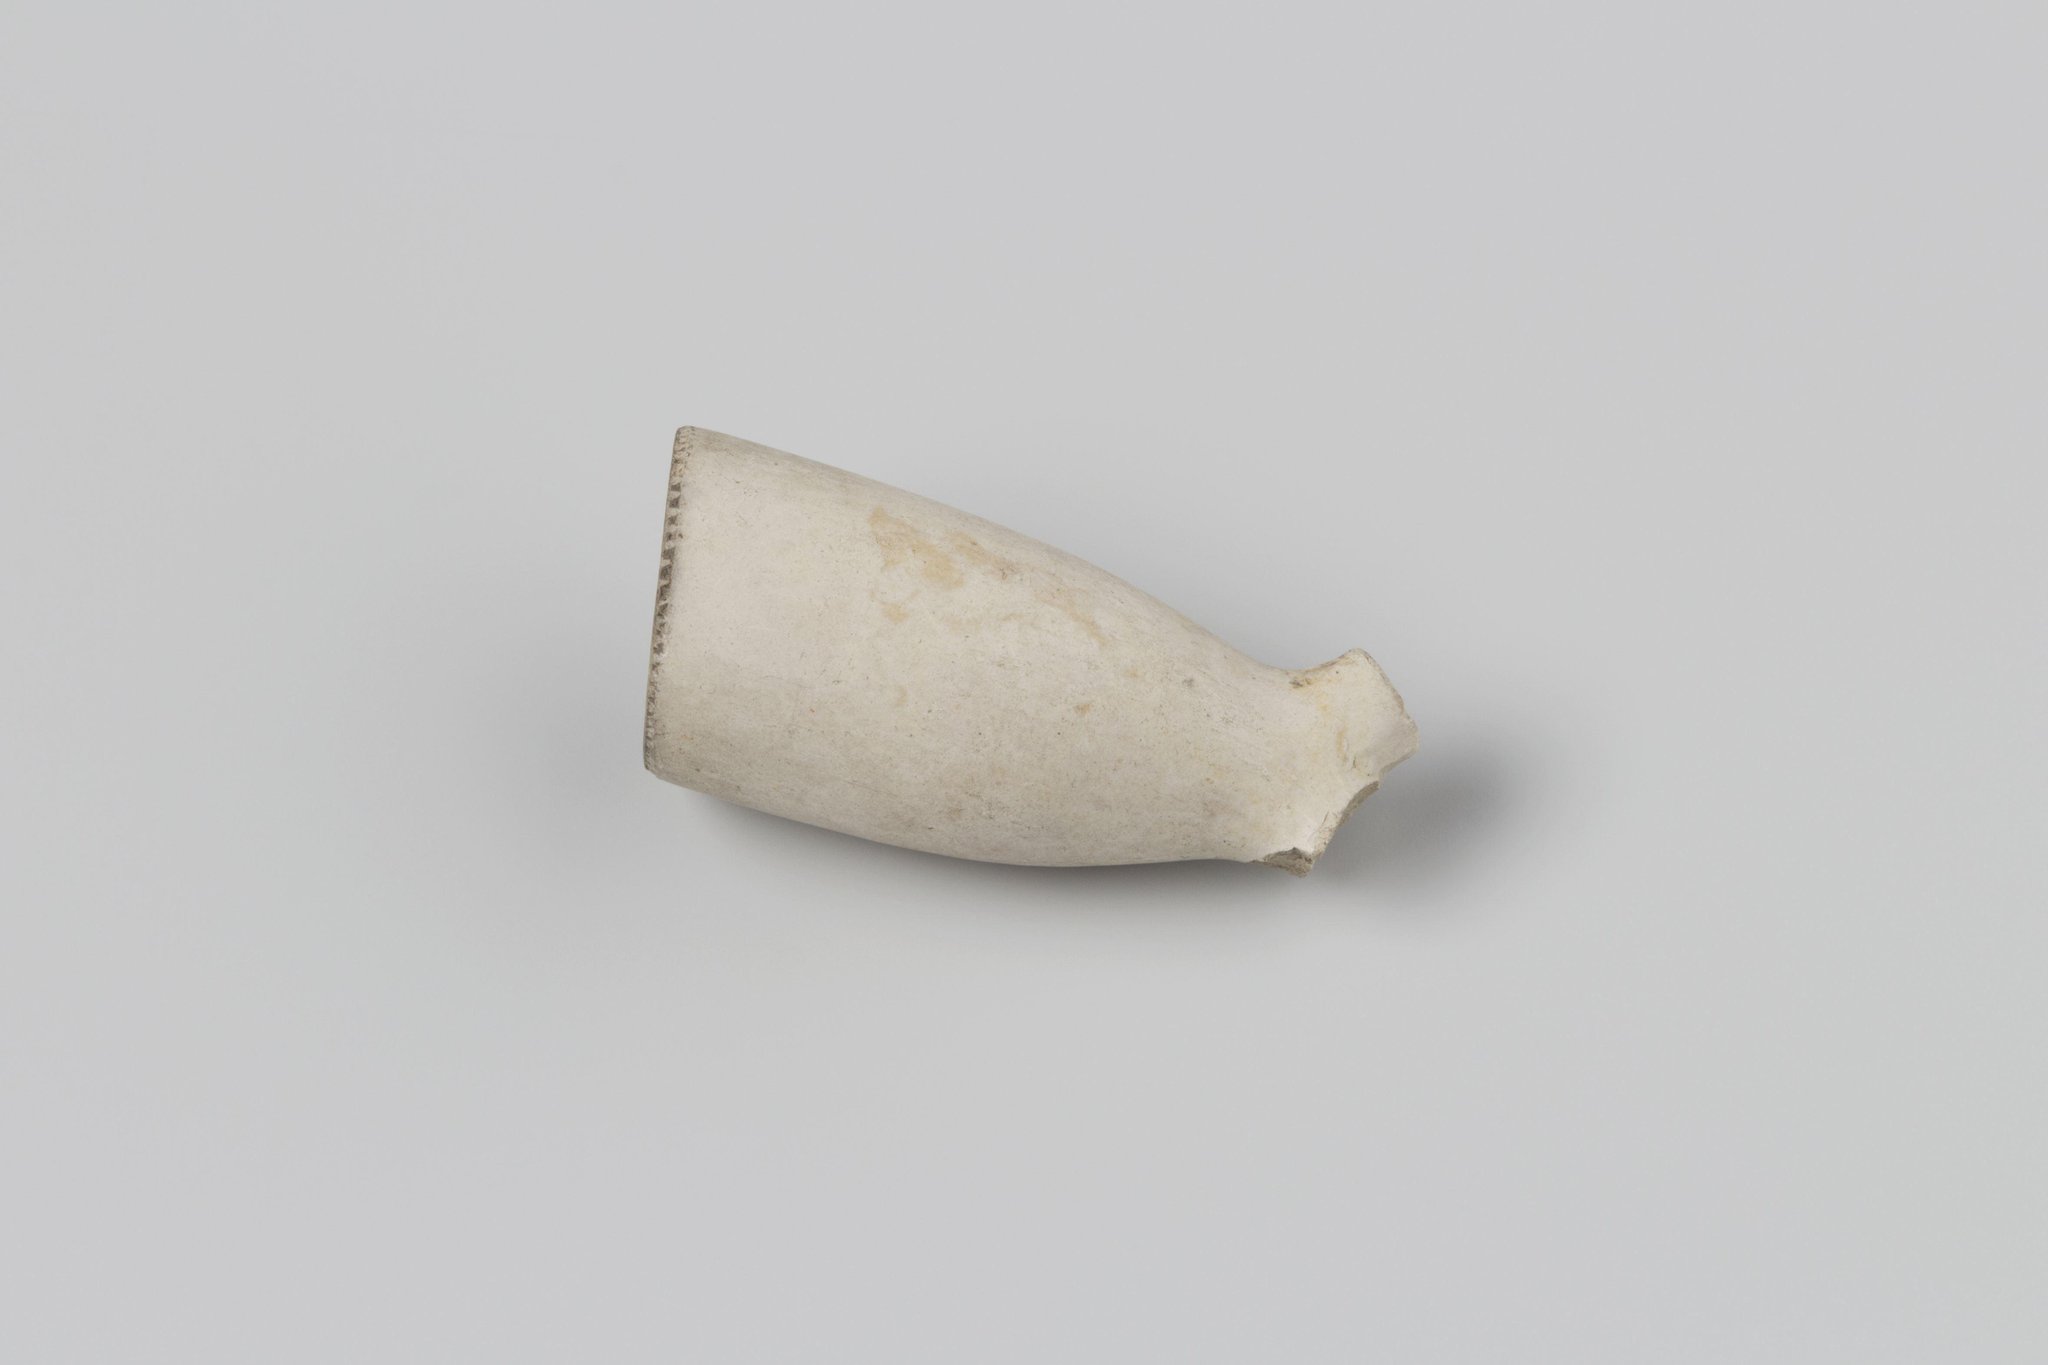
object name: pipe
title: Fragment pijpenkop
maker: Anonymous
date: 1720-1735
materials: clay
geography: gouda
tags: directeur, hoogleraar, caspar jacob christiaan reuvens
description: Fragment pijpenkop. Van de opgravingen op de Hofstede Arentsburg 1827-1831 onder toezicht van Professor Reuvens.